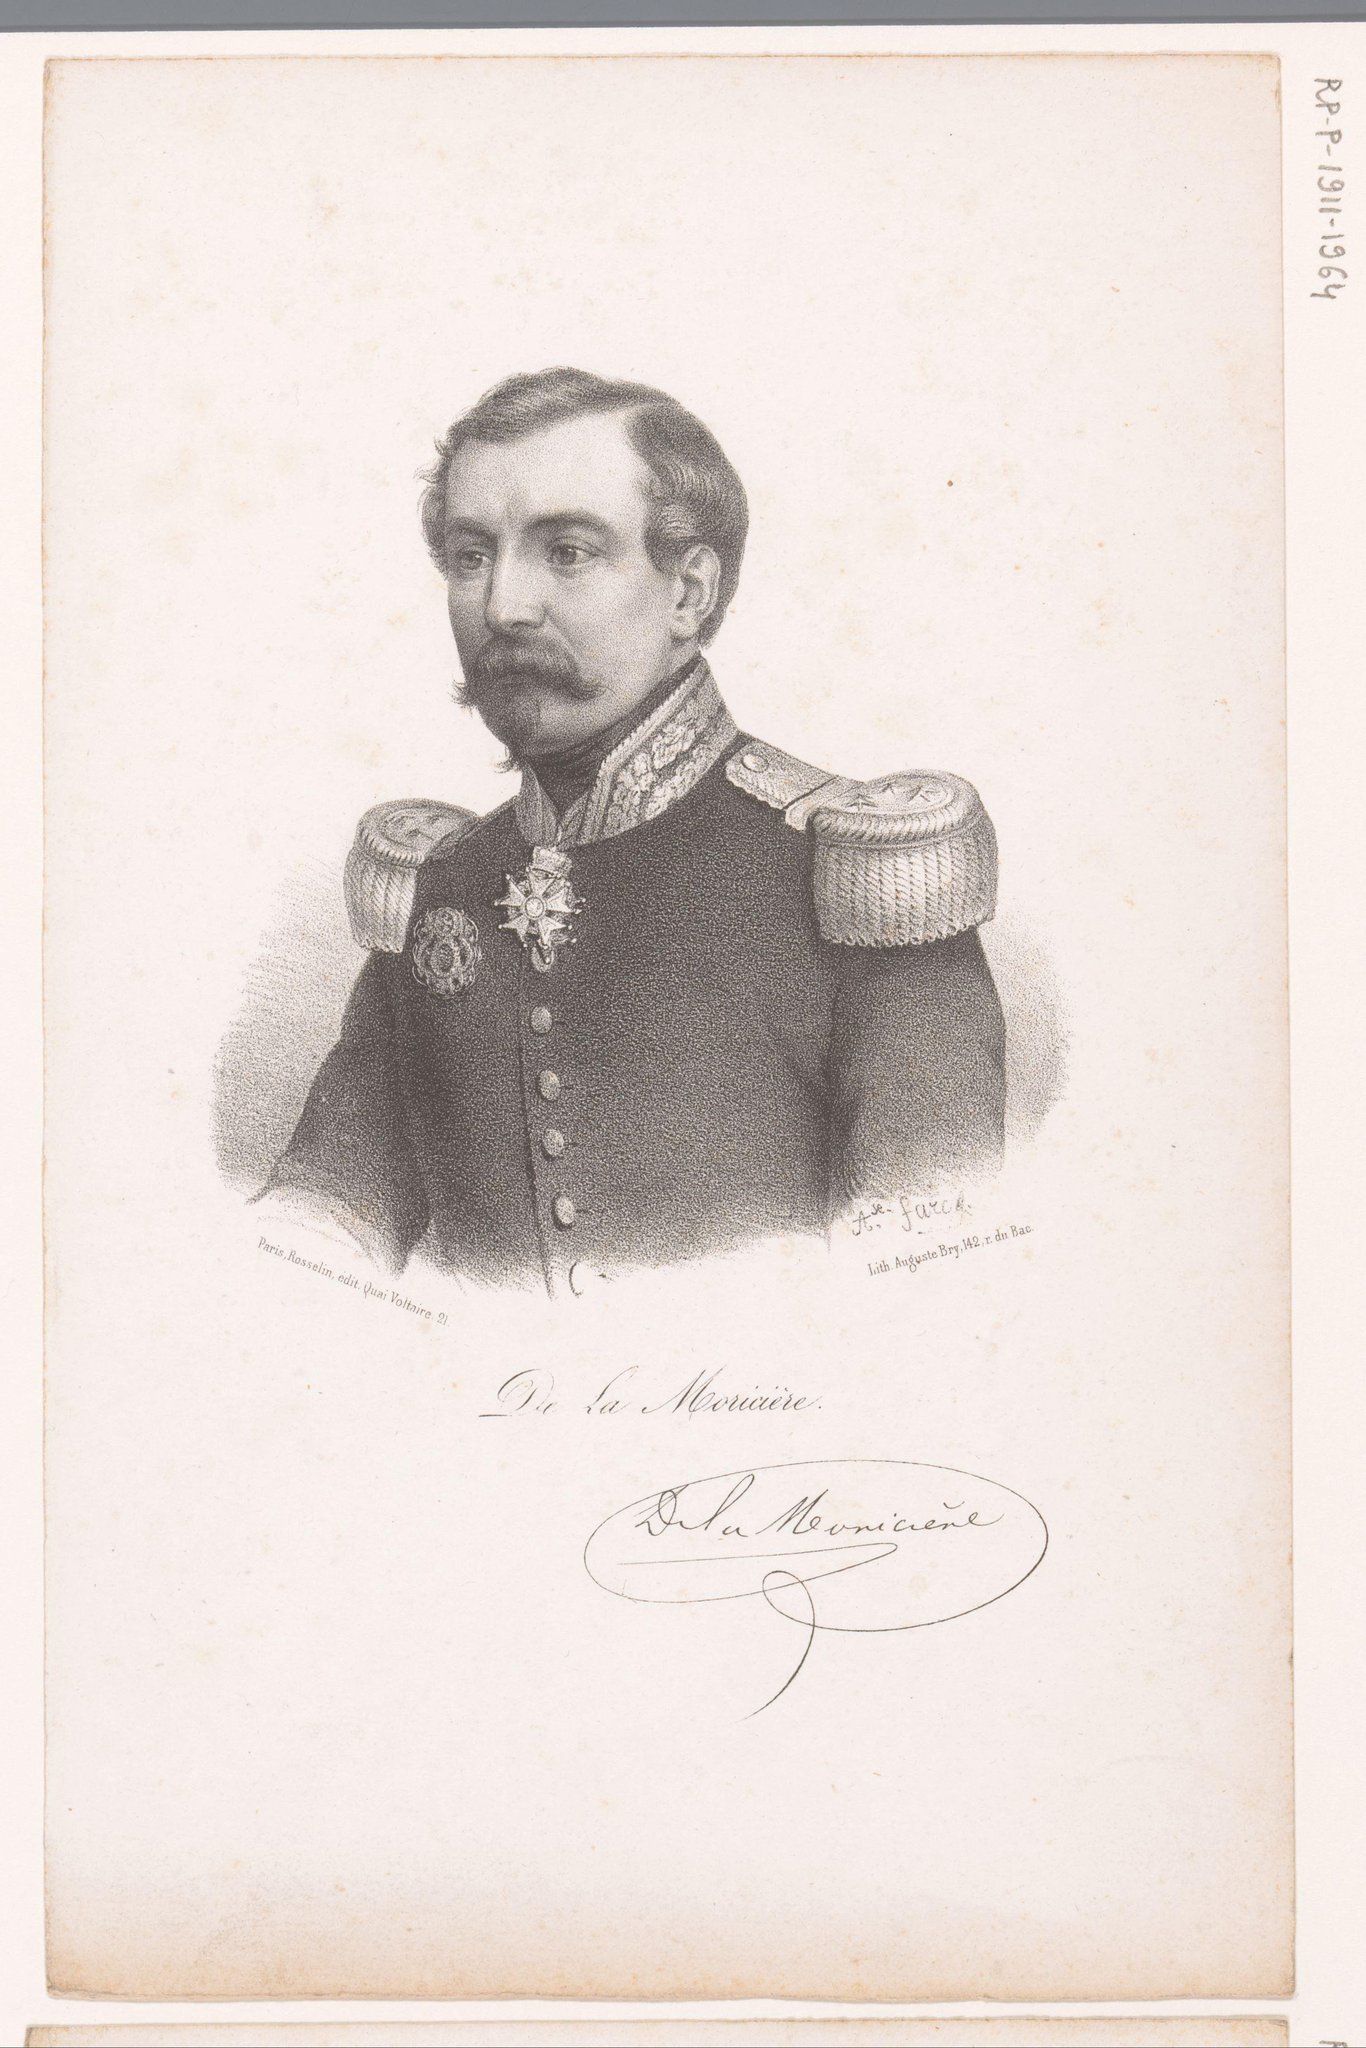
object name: print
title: De la Moricière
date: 1849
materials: paper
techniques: lithograph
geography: paris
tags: historical persons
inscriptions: collector's mark: Lugt 2228a